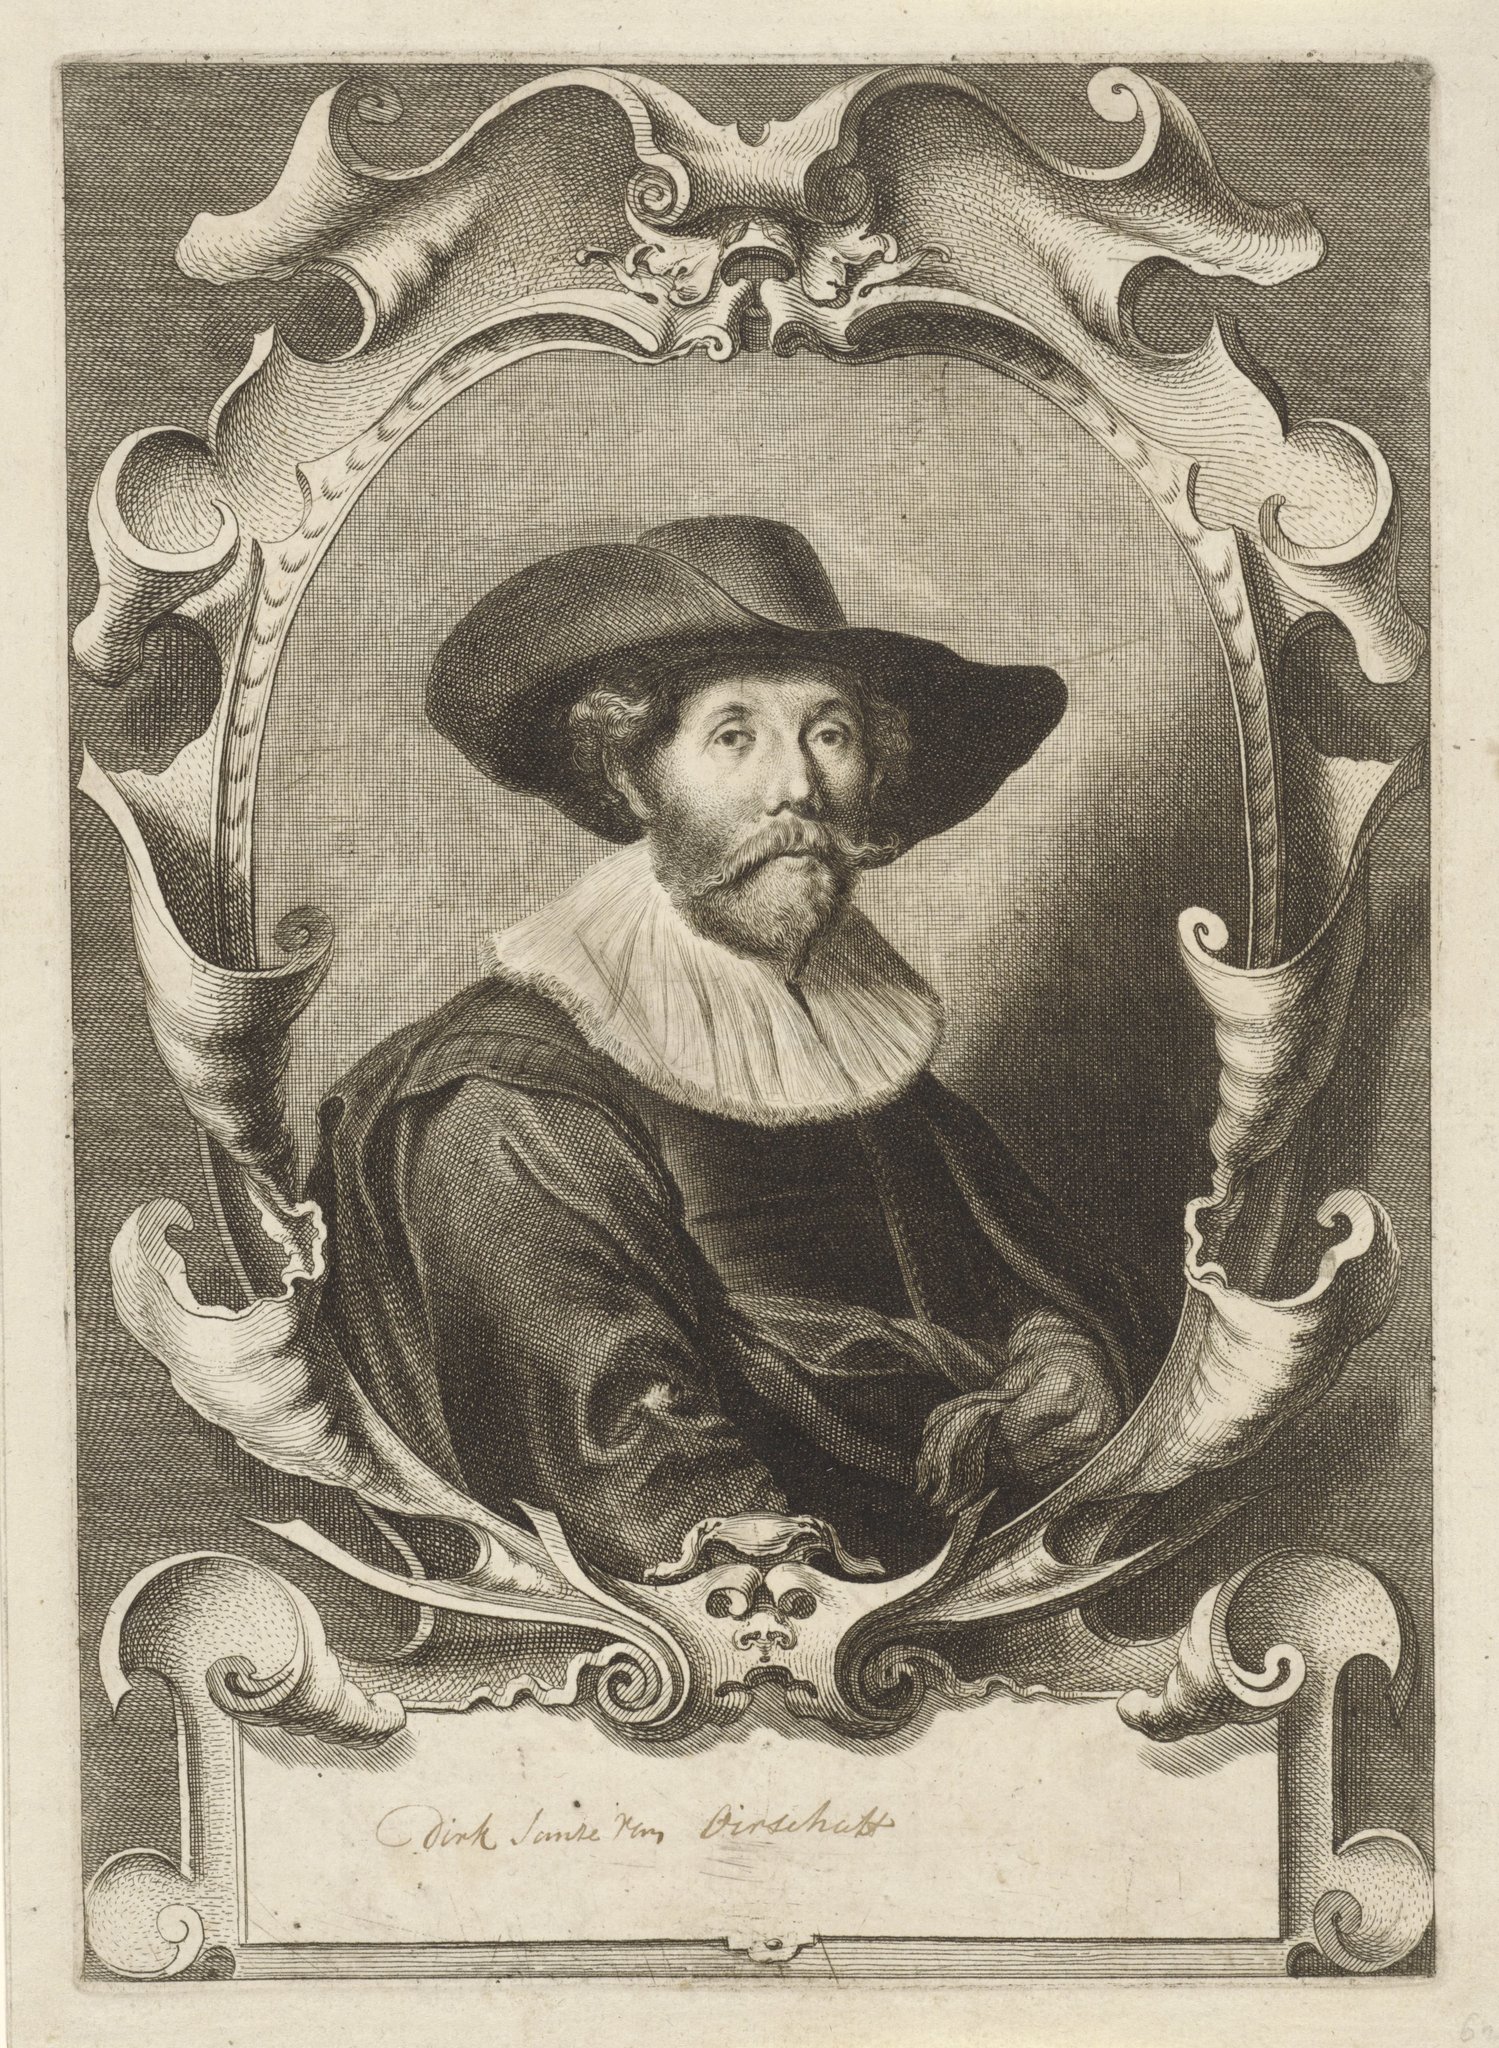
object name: print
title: Portret van Dirck Jansz. van Oirschott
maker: salomon savery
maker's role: print maker, publisher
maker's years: 1594-1683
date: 1610-1665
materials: paper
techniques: engraving, etching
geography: amsterdam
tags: kalligraaf, dirck jansz. van oirschott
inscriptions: collector's mark: Lugt 2228